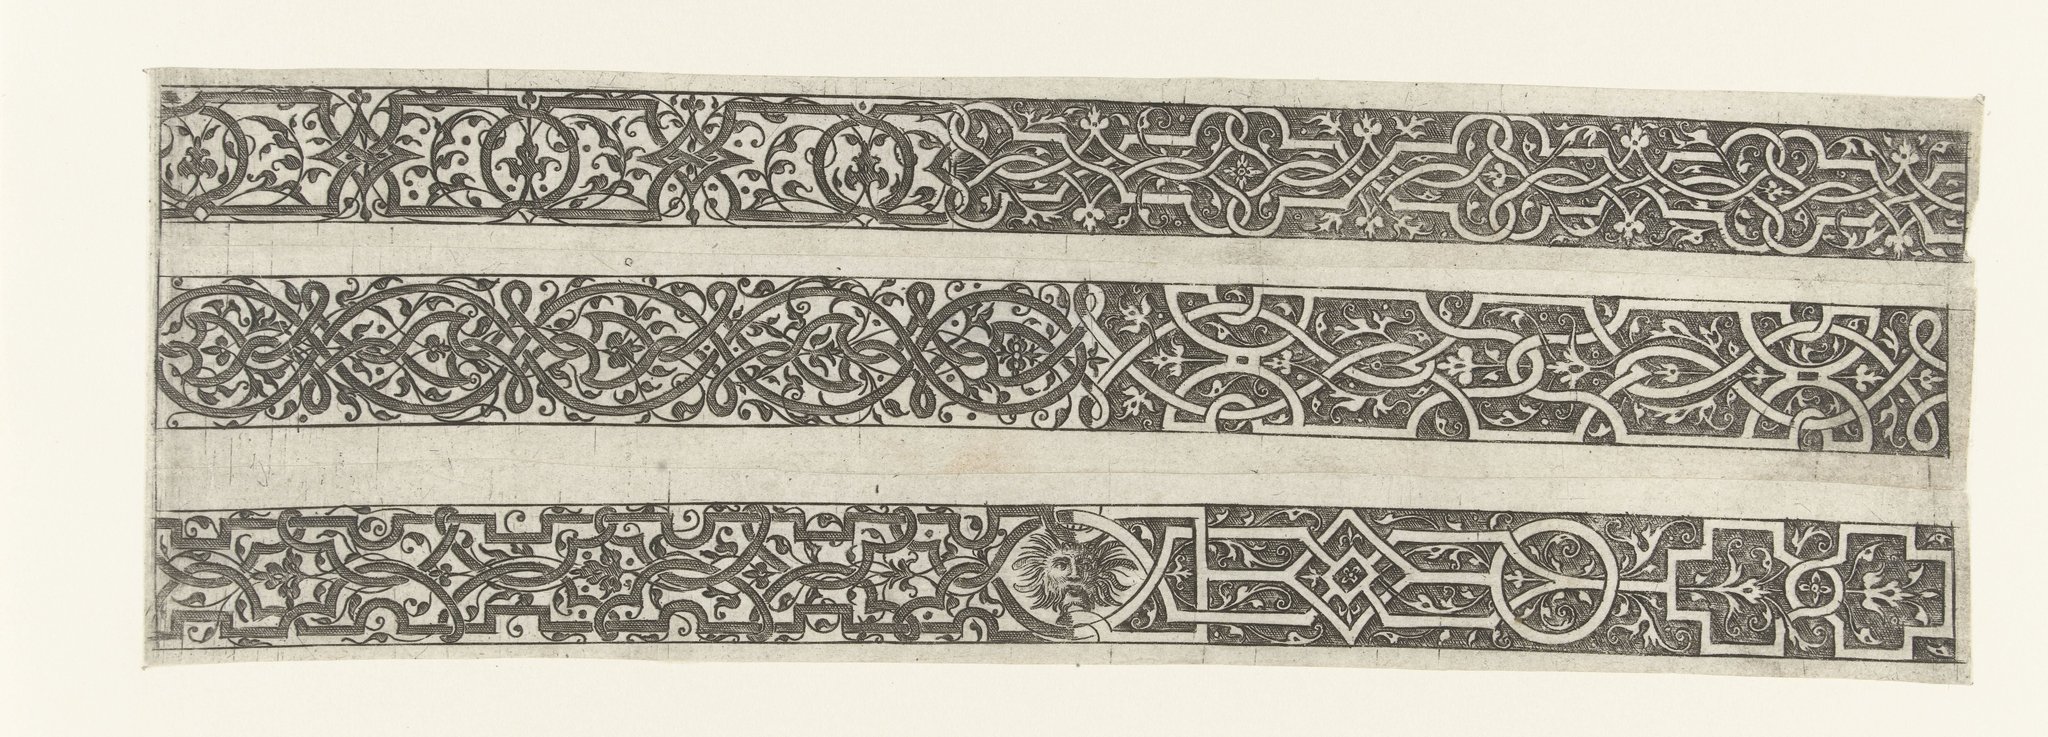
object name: print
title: Variarum protractionum quas vulgo maurusias vocant (...)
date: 1550-1580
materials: paper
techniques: engraving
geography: netherlands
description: Drie friezen met moresken, waarvan het linker deel bestaat uit zwarte moresken op een witte achtergrond en het rechter deel uit witte moresken op een donker fonf. In het bovenste fries bevindt de grens tussen beide delen zich links van het midden. Een van 15 bladen afkomstig uit een serie van 23 met titelblad.